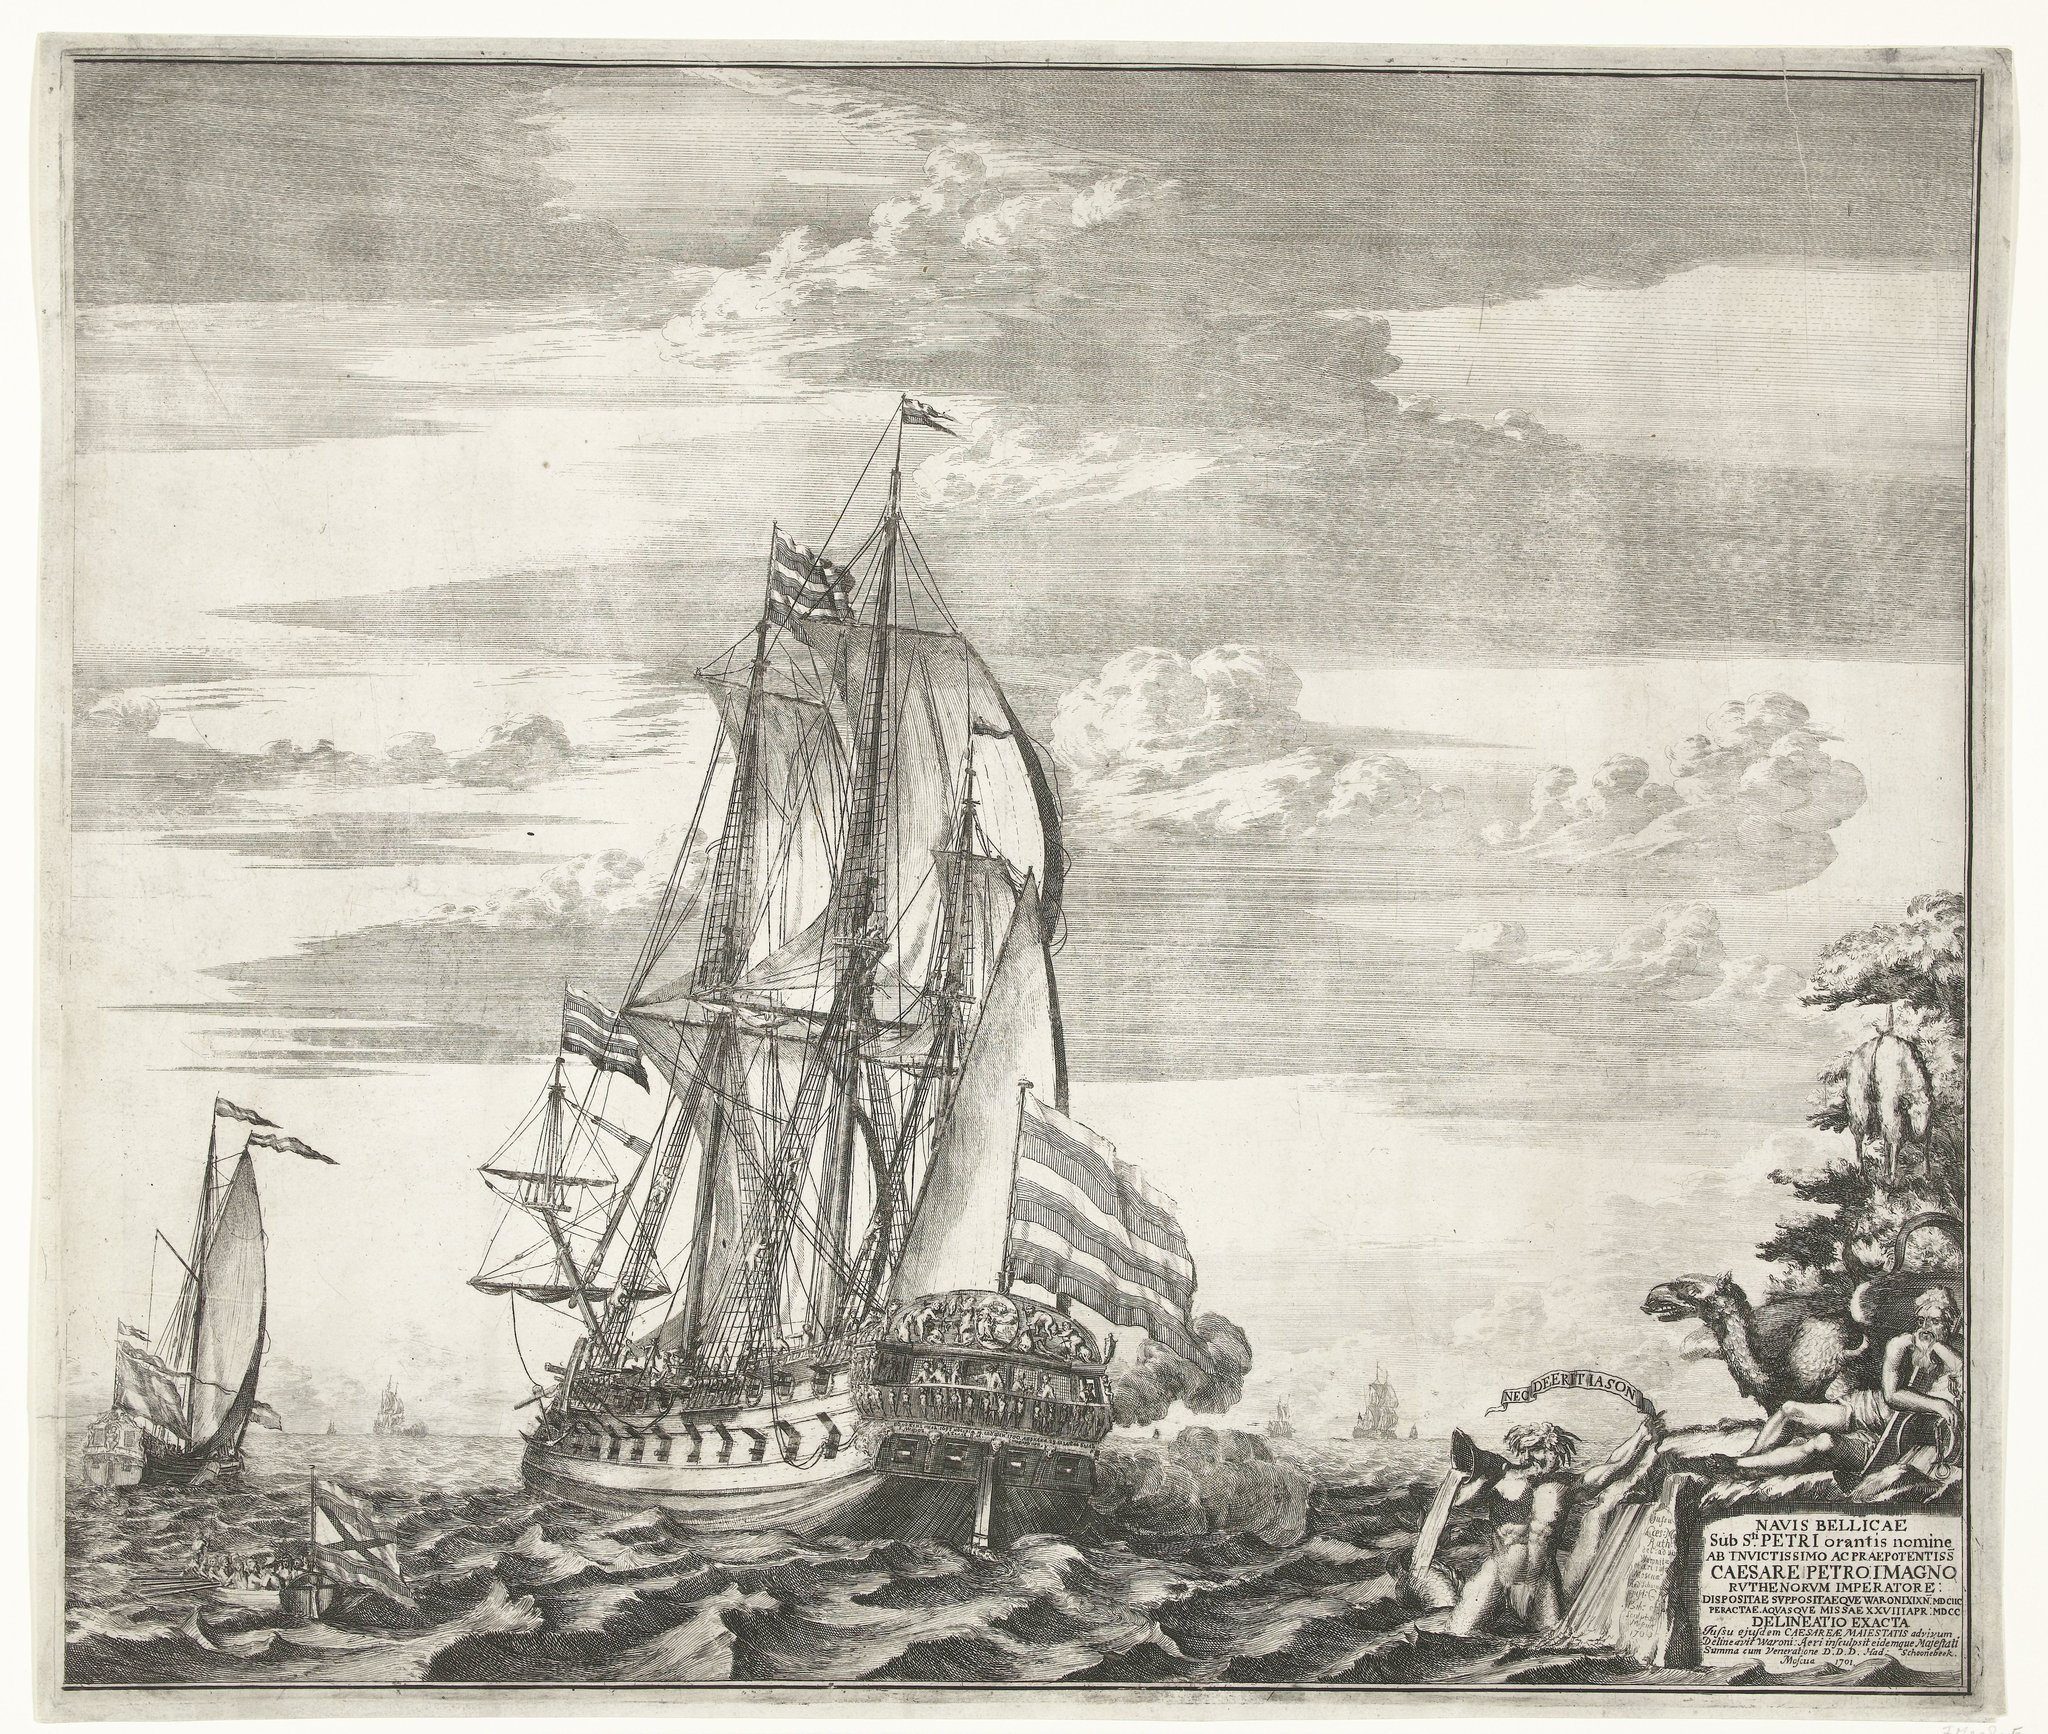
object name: print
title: Oorlogschip 'De Biddende Petrus' ontworpen door Peter de Grote, 1700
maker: adriaen schoonebeek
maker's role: print maker, publisher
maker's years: 1661-1705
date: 1701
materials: paper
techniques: engraving, etching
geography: moscow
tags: peter i de grote (tsaar van rusland), (military) training ship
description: Het Oorlogschip 'De Biddende Petrus' ontworpen door tsaar Peter de Grote en op 28 april 1700 van stapel gelopen. Op de spiegel een tekst in het Russisch met de jaartallen 1698 en 1700, links op de voorgrond een sloep en een jacht. Rechts de cartouche met de titel in het Latijn, een triton, riviergod en draak.